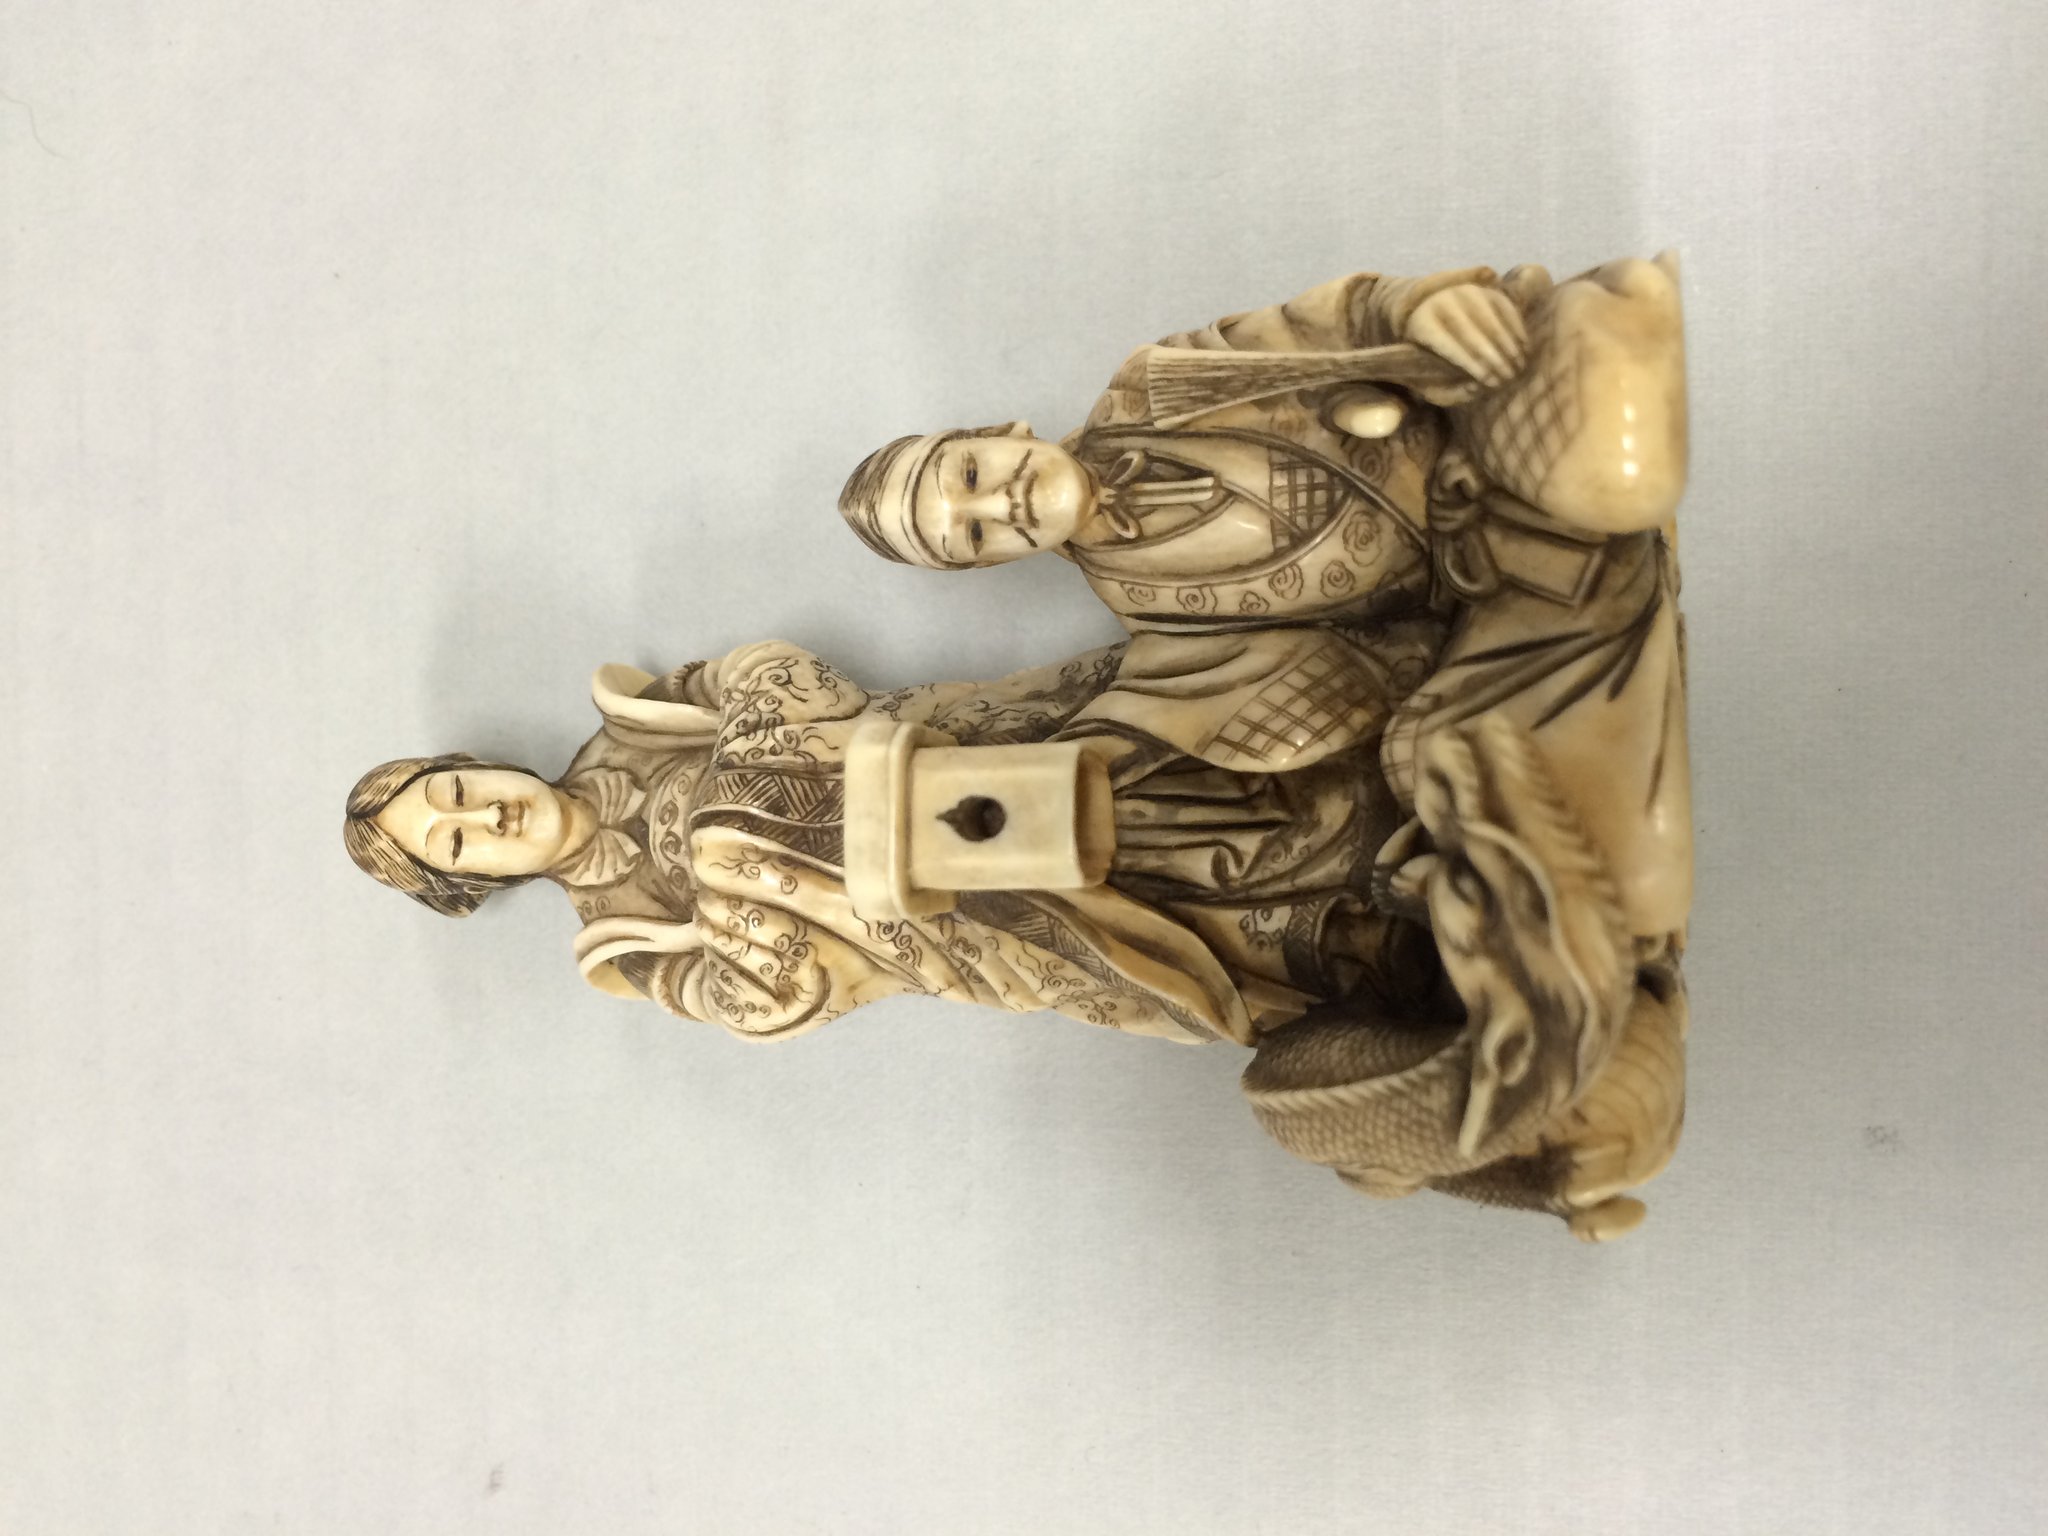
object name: netsuke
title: Two Figures and a Dragon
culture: japanese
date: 1801-1900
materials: ivory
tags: men,dragons